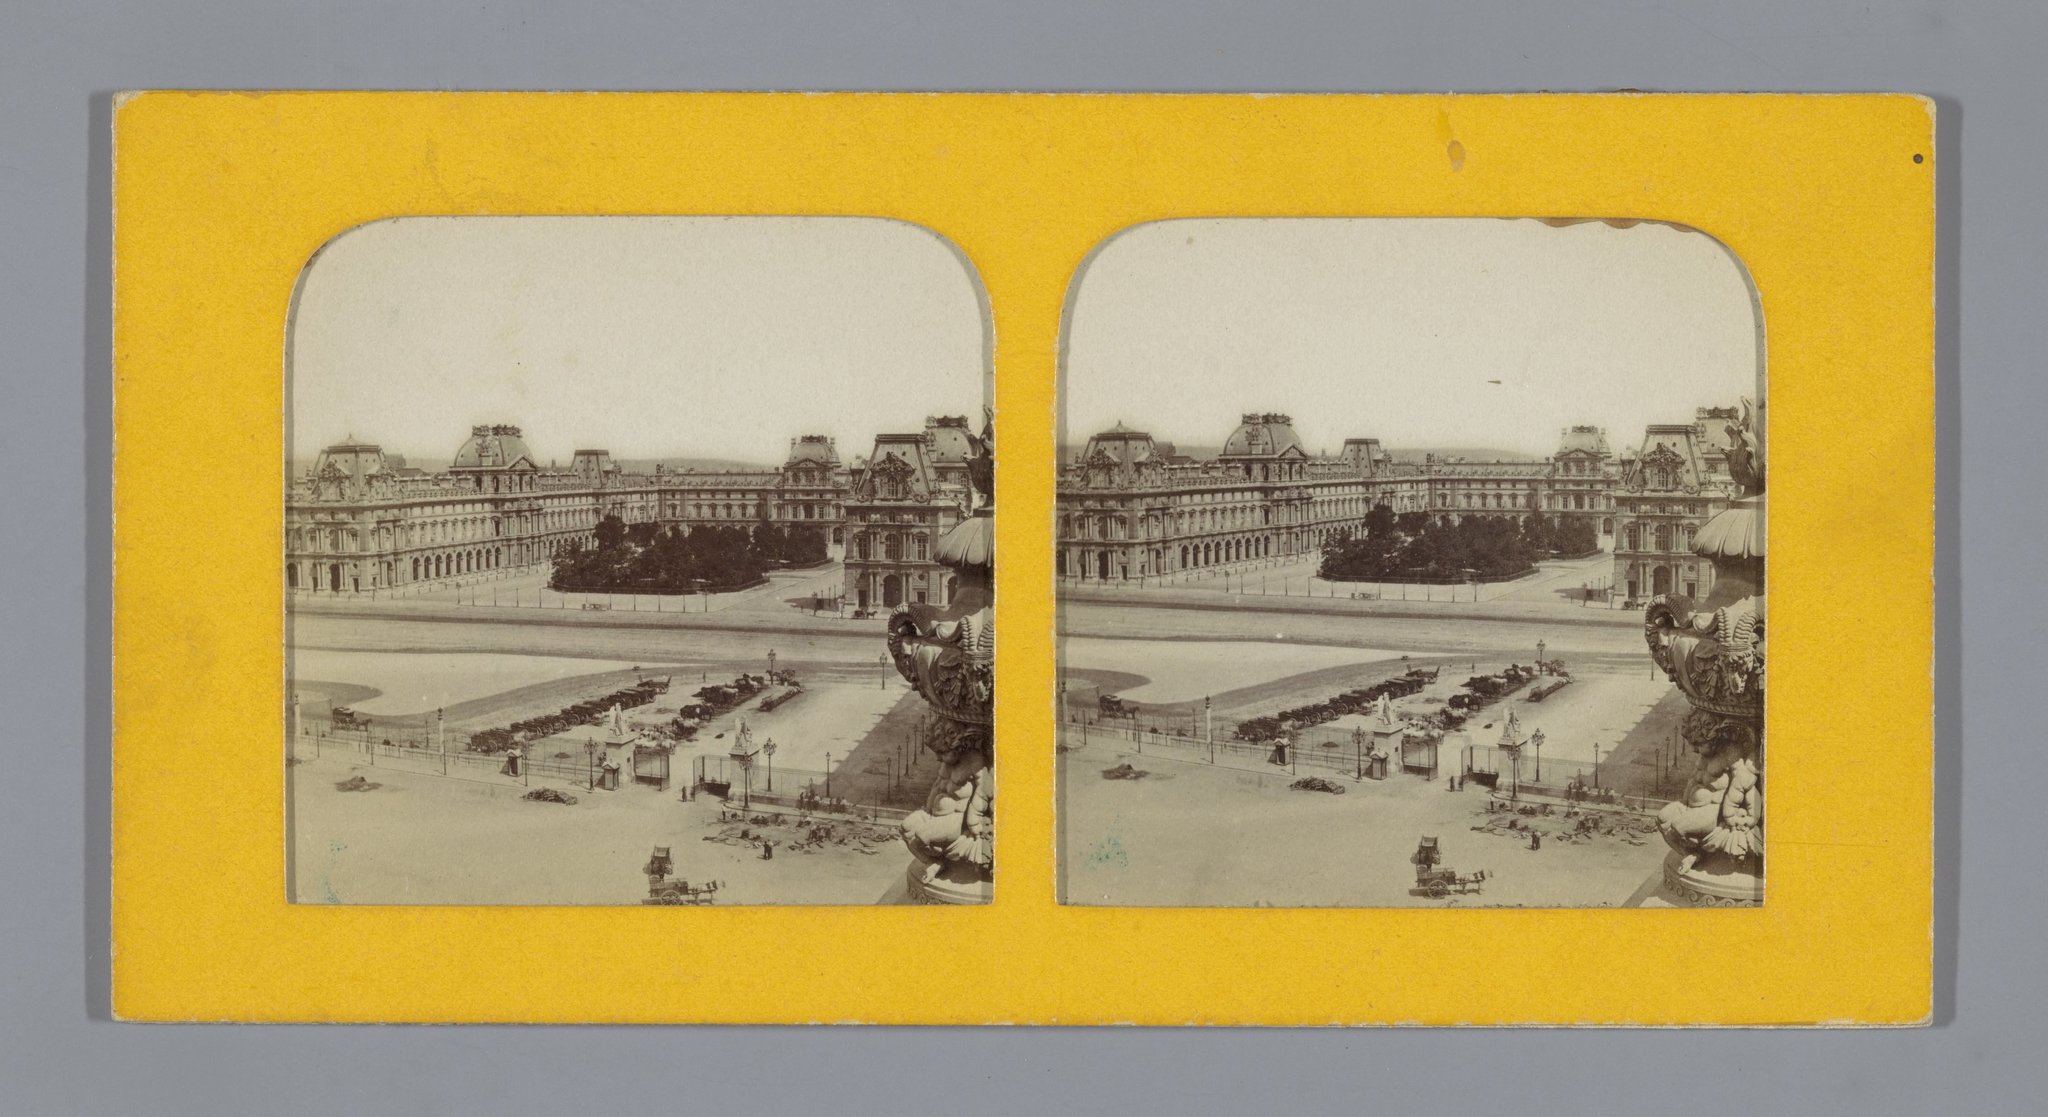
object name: tissue stereograph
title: Louvre, Paris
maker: Anonymous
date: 1855-1875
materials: cardboard, paper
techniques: albumen print, hand coloring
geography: paris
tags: palace, permanent exhibition, museum